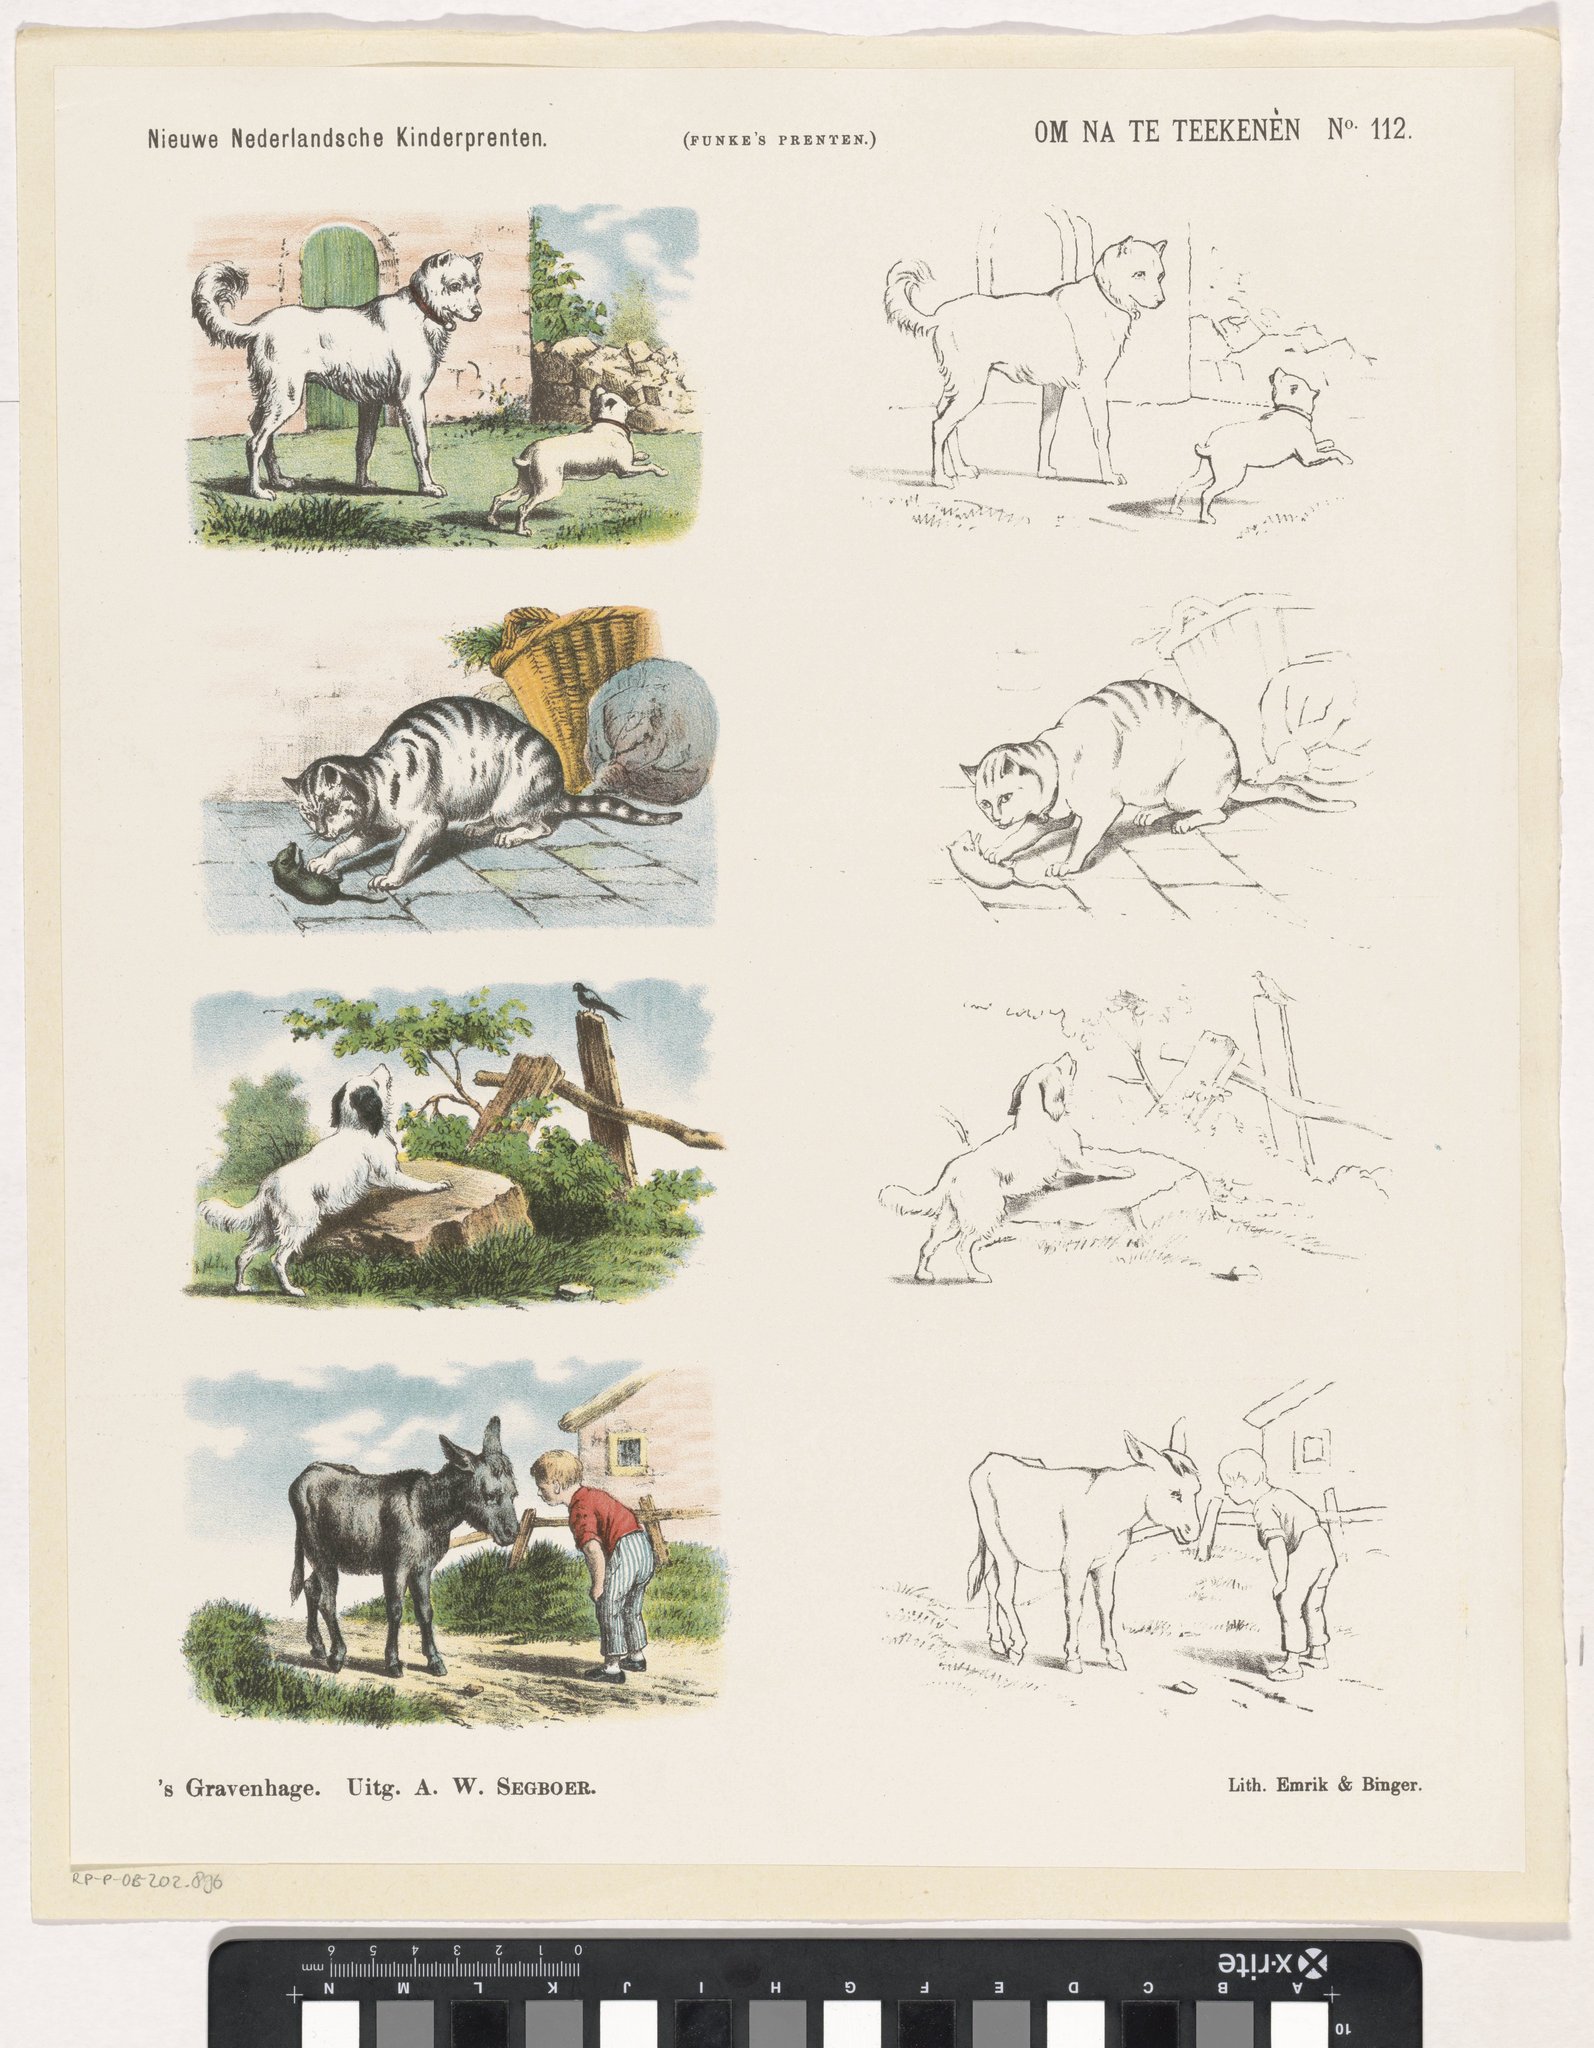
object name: print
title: Om na te teekenen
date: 1903-1919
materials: paper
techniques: lithograph, letterpress printing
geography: the hague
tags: animals, ass, donkey, cat and mouse, dog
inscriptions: collector's mark: Lugt 2760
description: Blad met 8 voorstellingen van dieren. Links onder elkaar vier ingekleurde afbeeldingen van honden, een kat en een ezel. Rechts dezelfde vier afbeeldingen met enkel de contouren in zwart. Genummerd rechtsboven: No. 112.